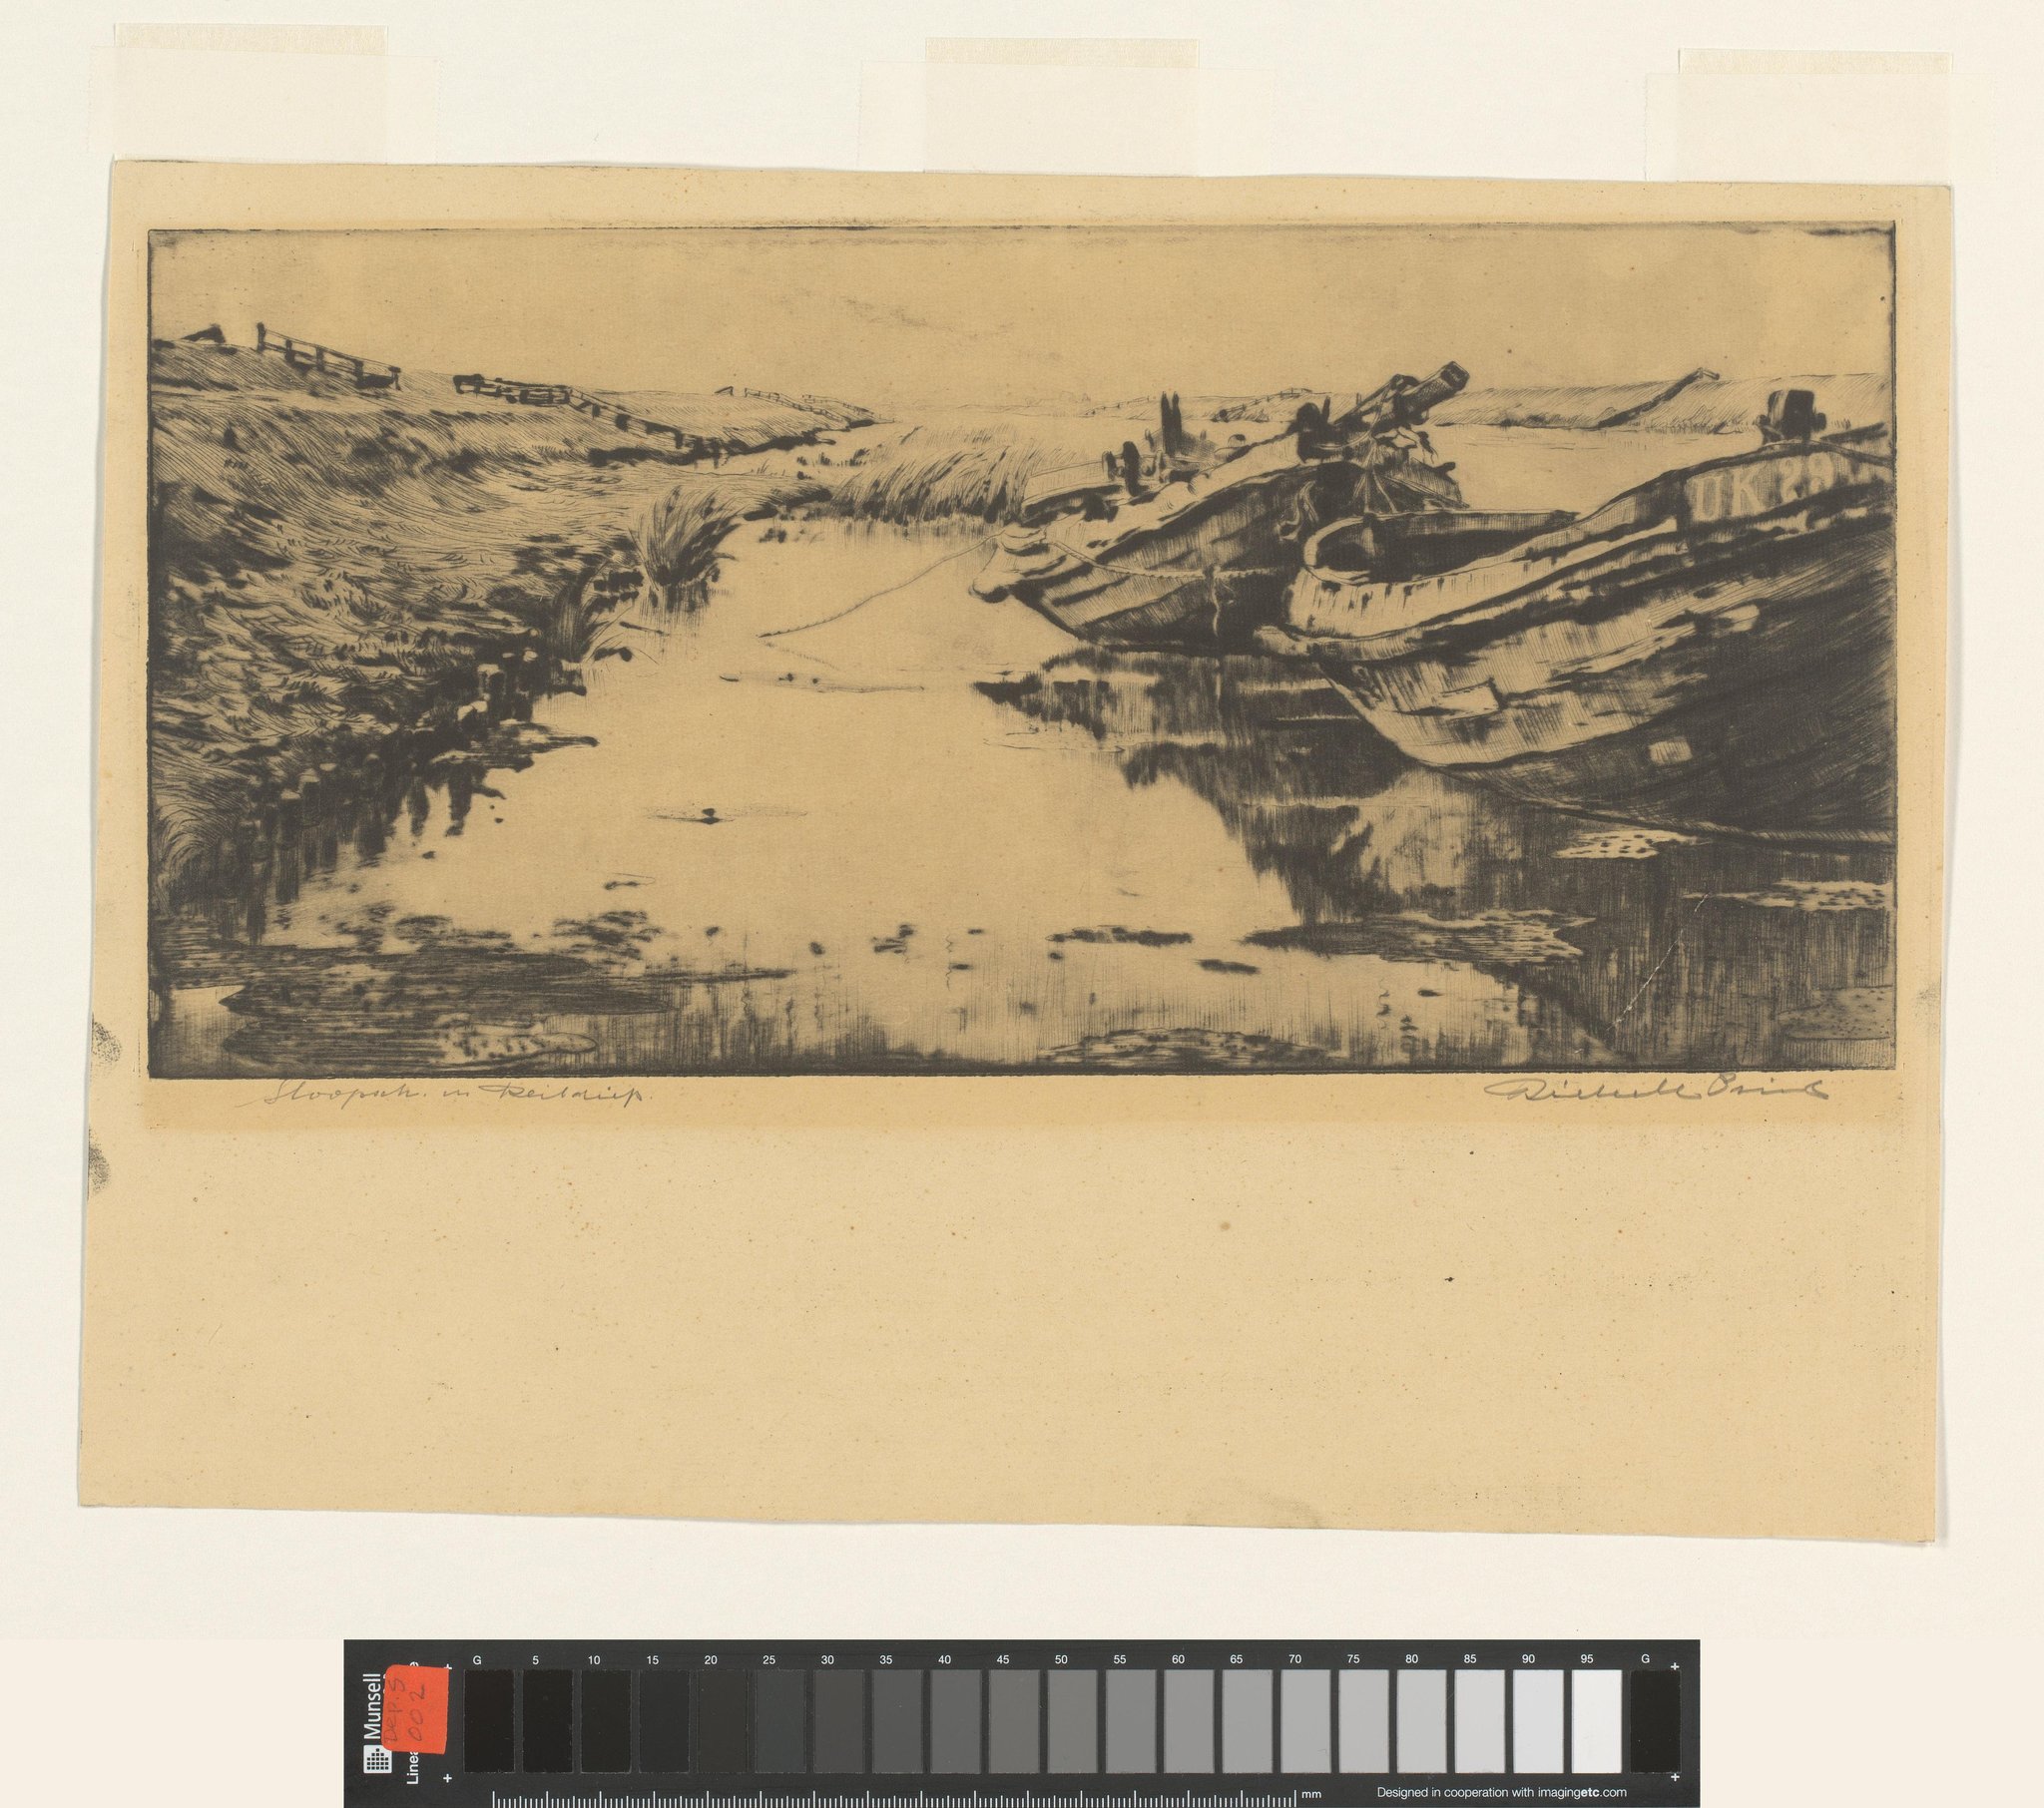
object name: print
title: Sloepen in Reitdiep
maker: riekele prins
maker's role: print maker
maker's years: 1905-1954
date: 1915-1941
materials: paper, ink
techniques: drypoint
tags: reitdiep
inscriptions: signature: ‘Riekele Prins’, title: ‘Sloepen in Reitdiep’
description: Twee sloepen in een kanaal met in de voorste een inzittende waarvan alleen de hogehoed te zien is.